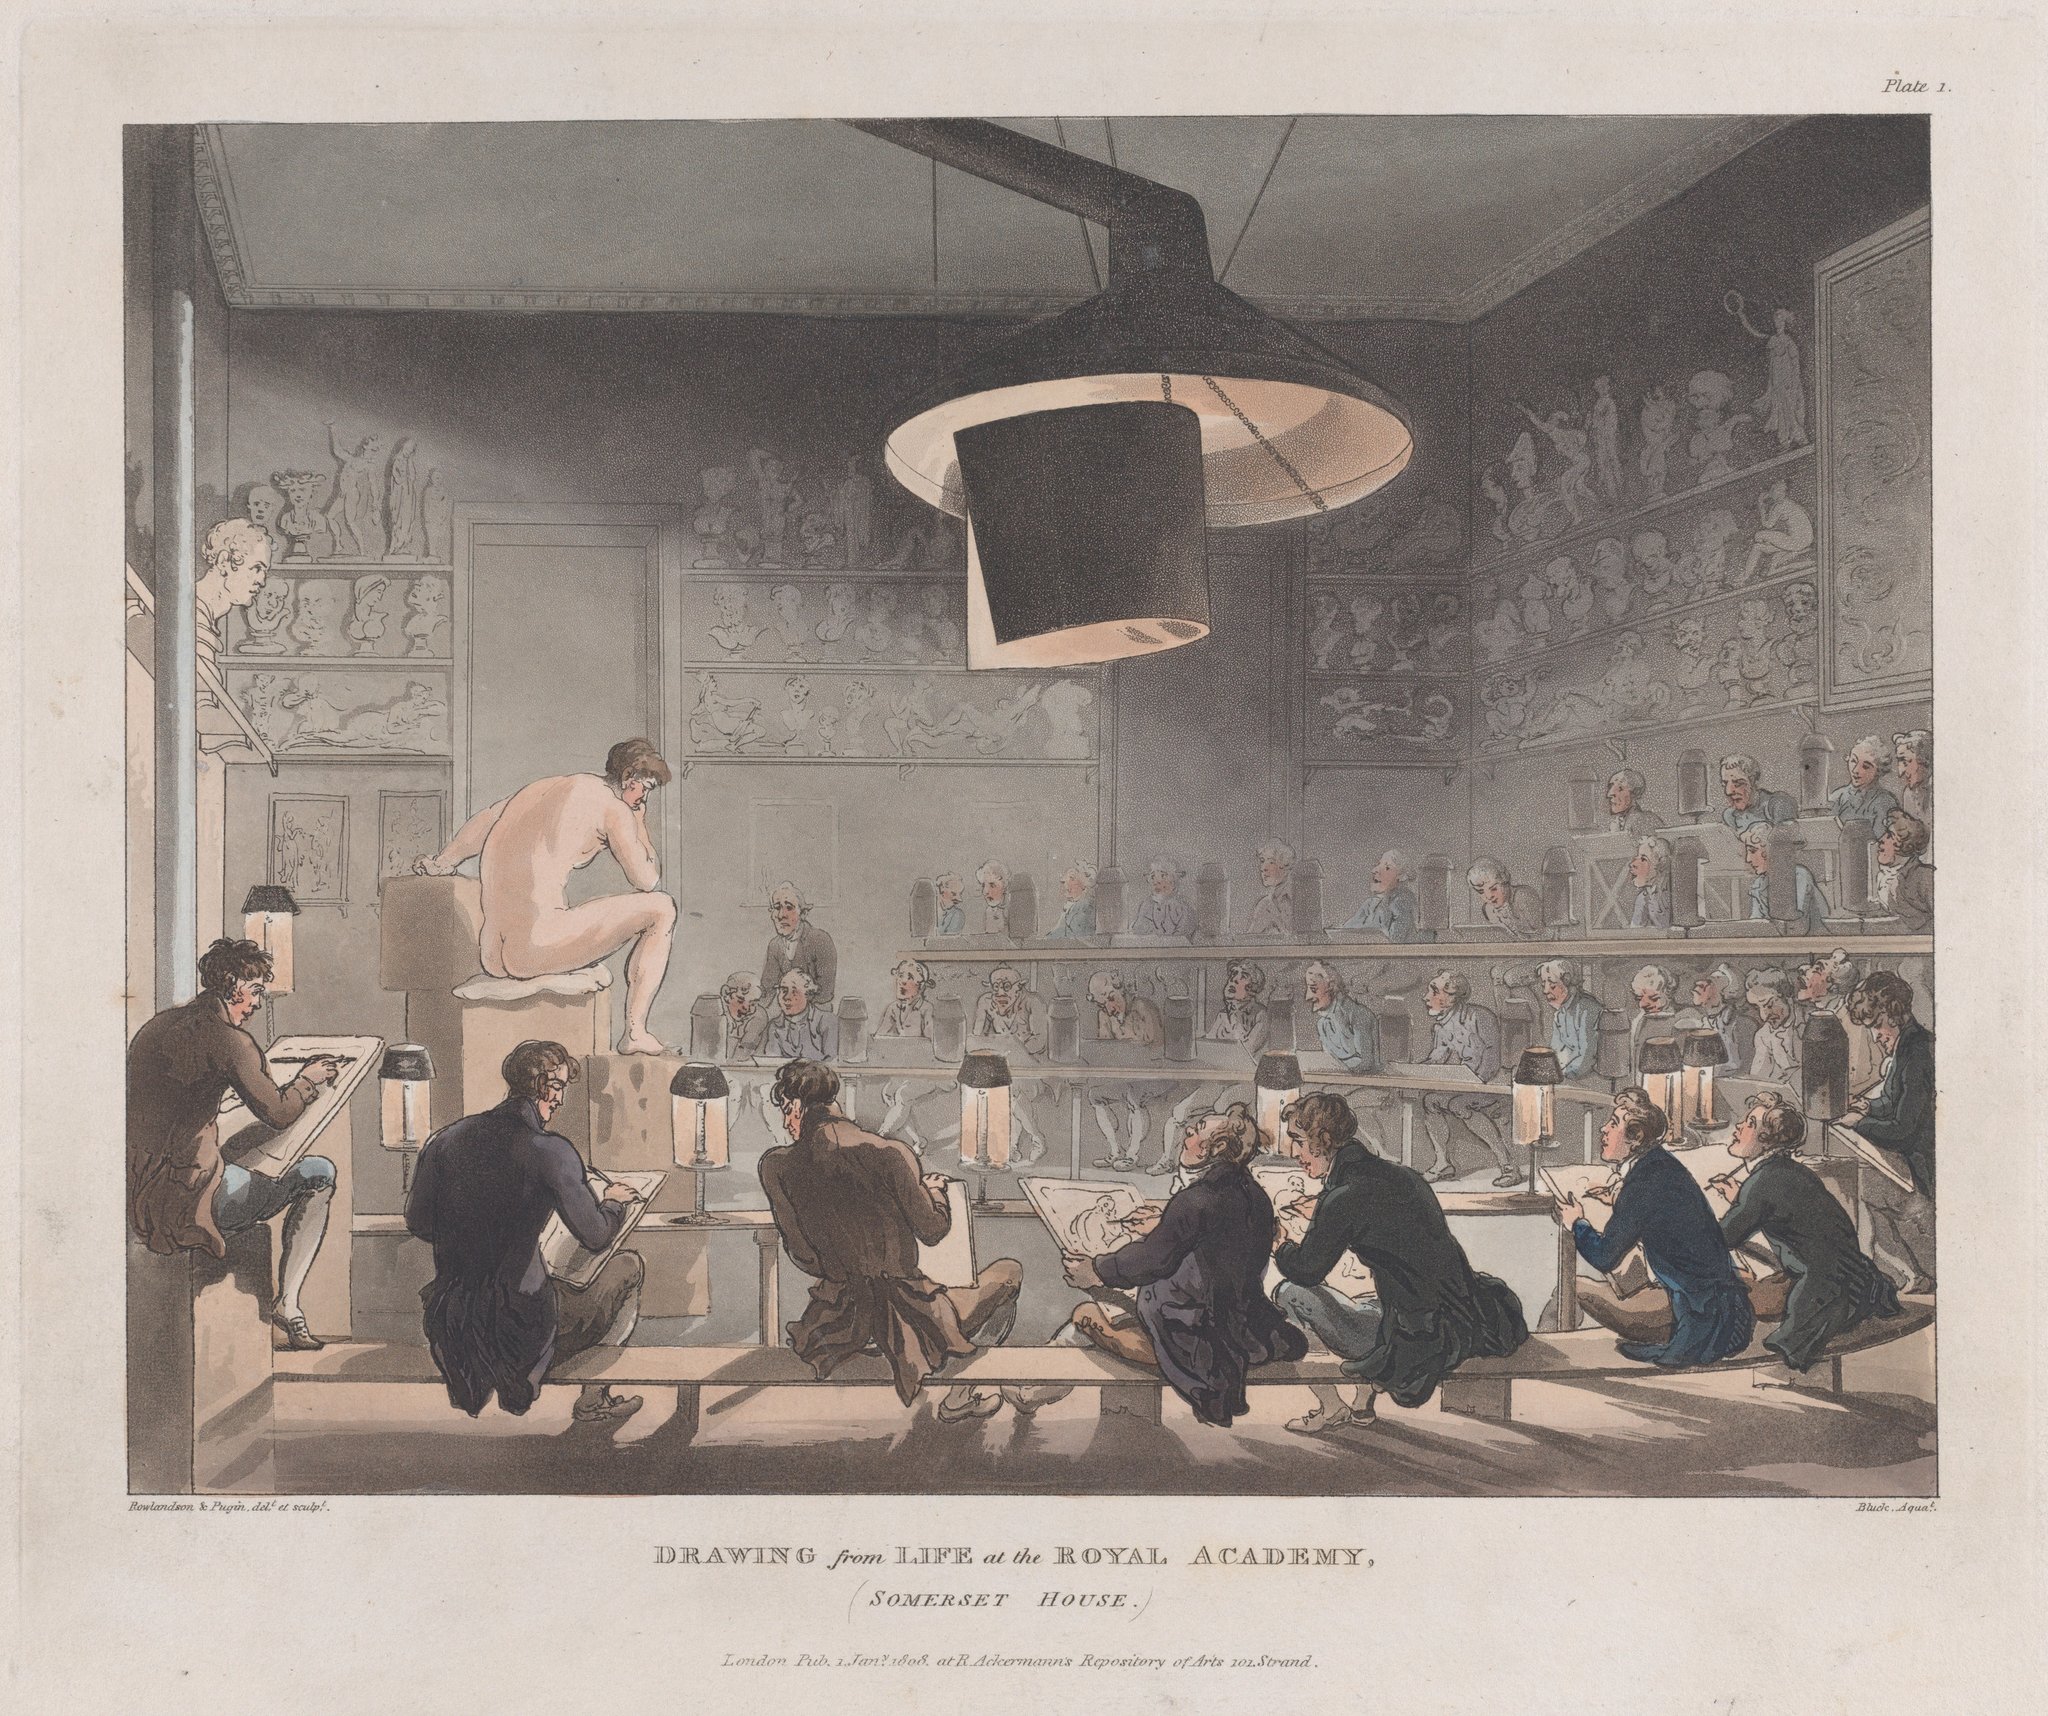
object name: print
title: Drawing from Life at the Royal Academy, Somerset House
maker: thomas rowlandson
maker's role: artist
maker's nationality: british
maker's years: 1757-1827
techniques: aquatint, etching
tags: drawing,men,students,artists